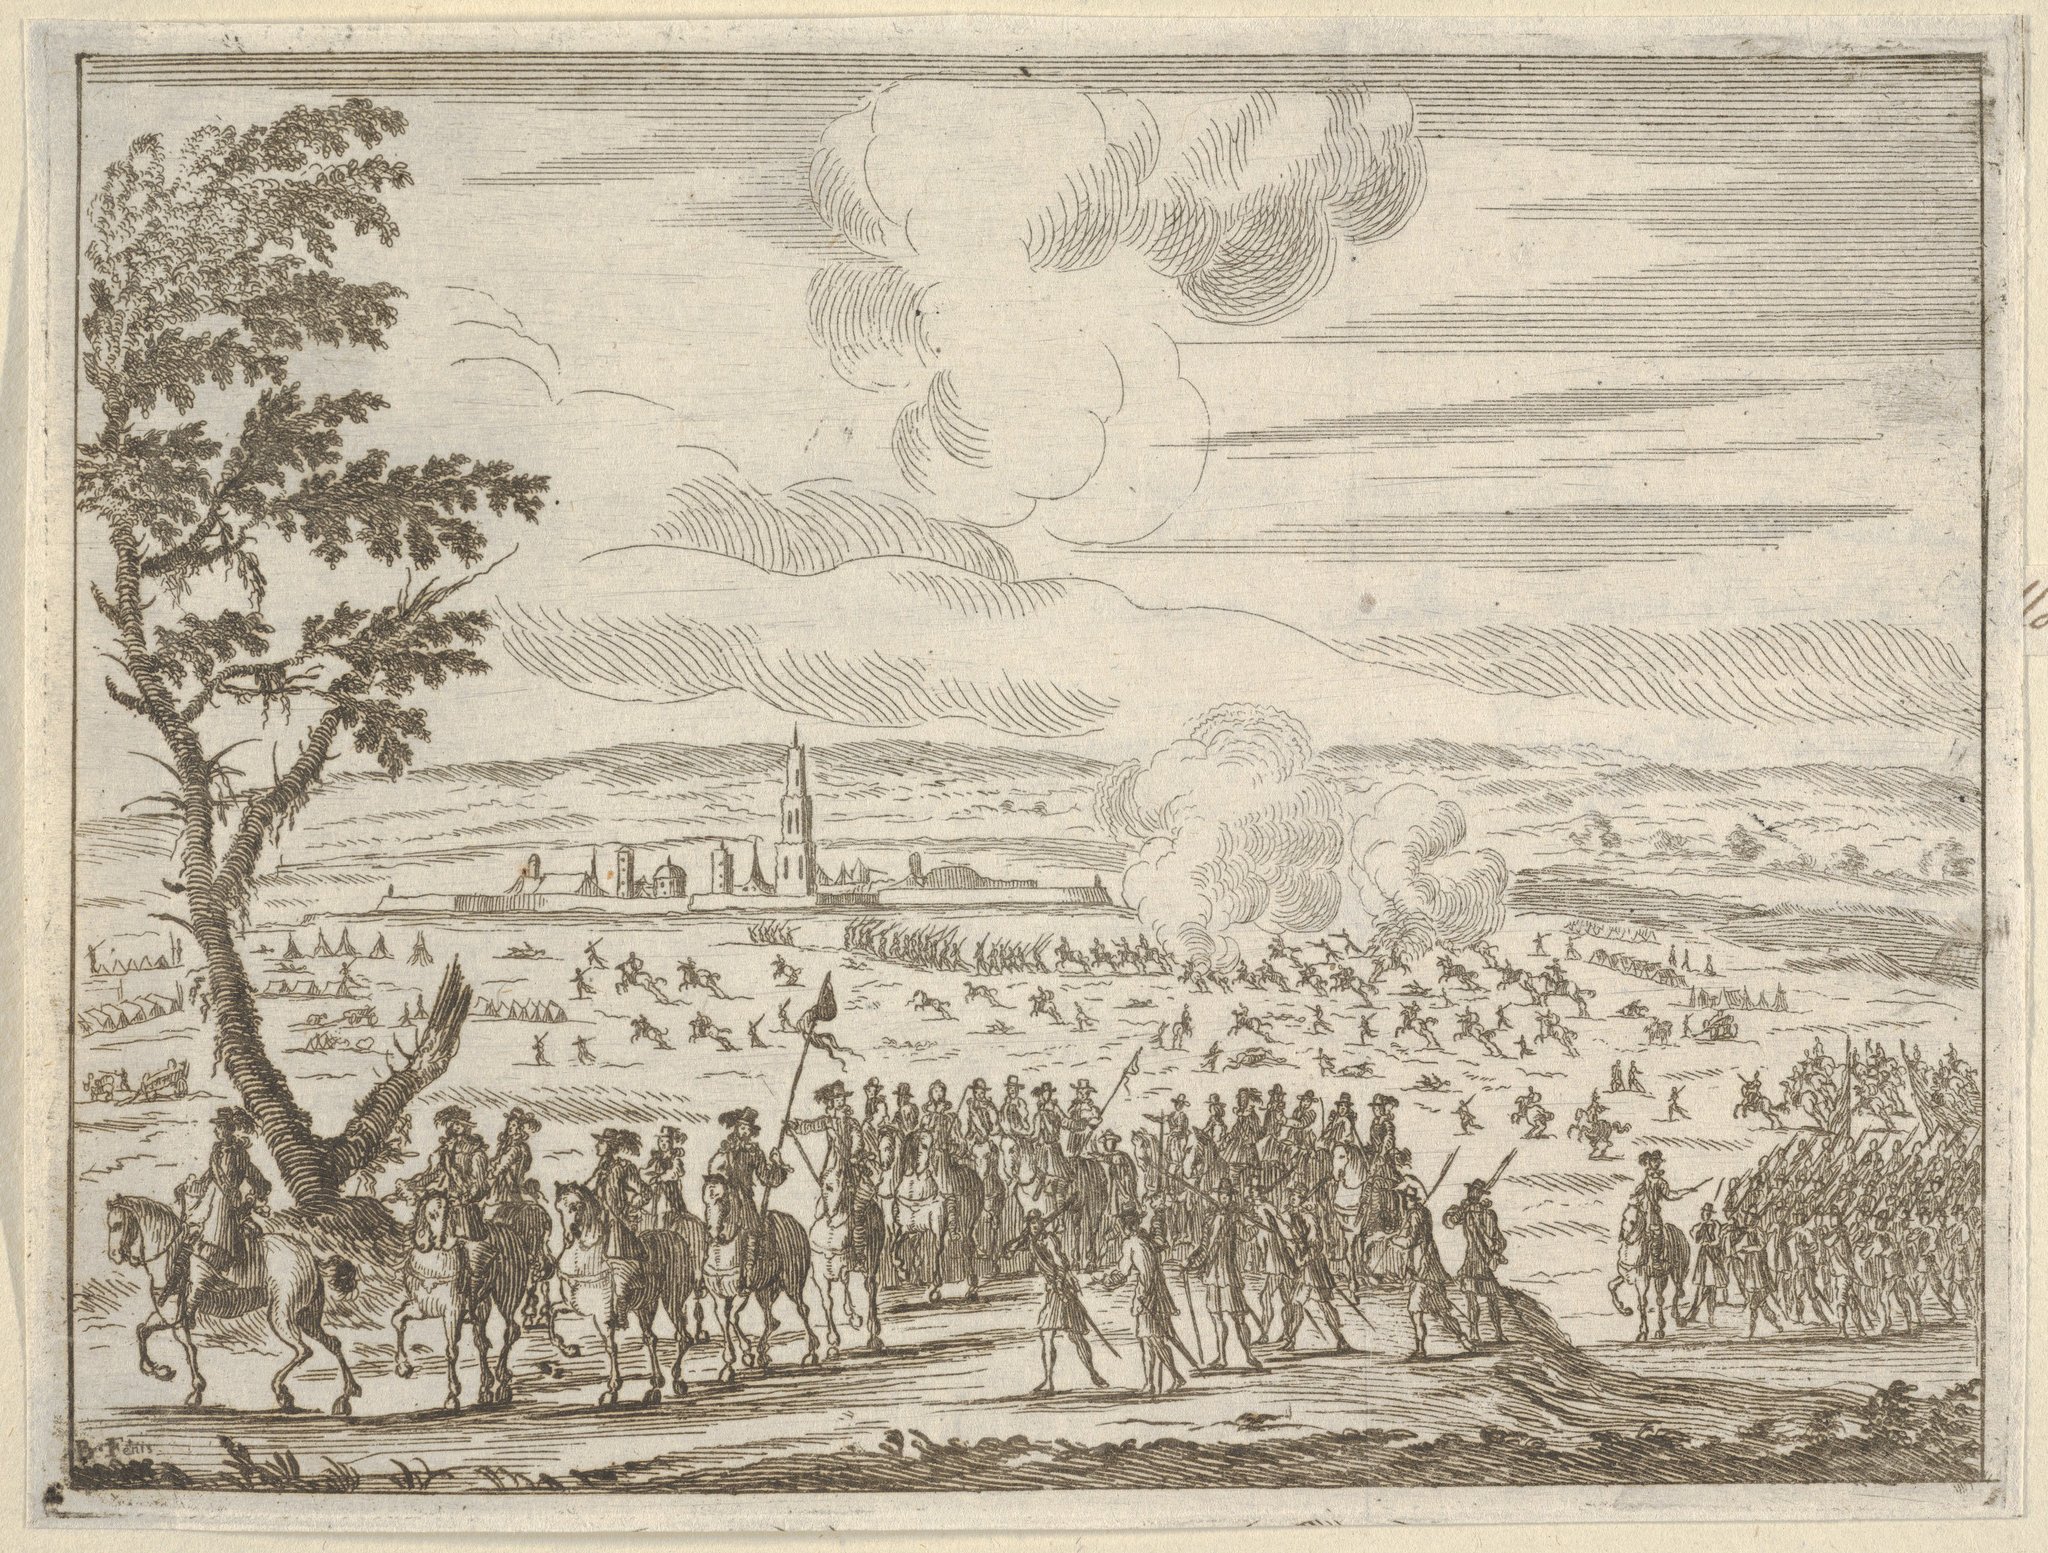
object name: print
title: Francesco d'Este Leads the French Army After the Difficult Resolution of Cremona without Losing Men or Belongings due to the Duke's Prudence and Corageous Strength, from "L'Idea di un Principe ed Eroe Cristiano in Francesco I d'Este, di Modena e Reggio Duca VIII [...]"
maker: bartolomeo fenice (fénis)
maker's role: artist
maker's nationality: italian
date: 1659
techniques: etching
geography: italy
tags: army,horses,trees